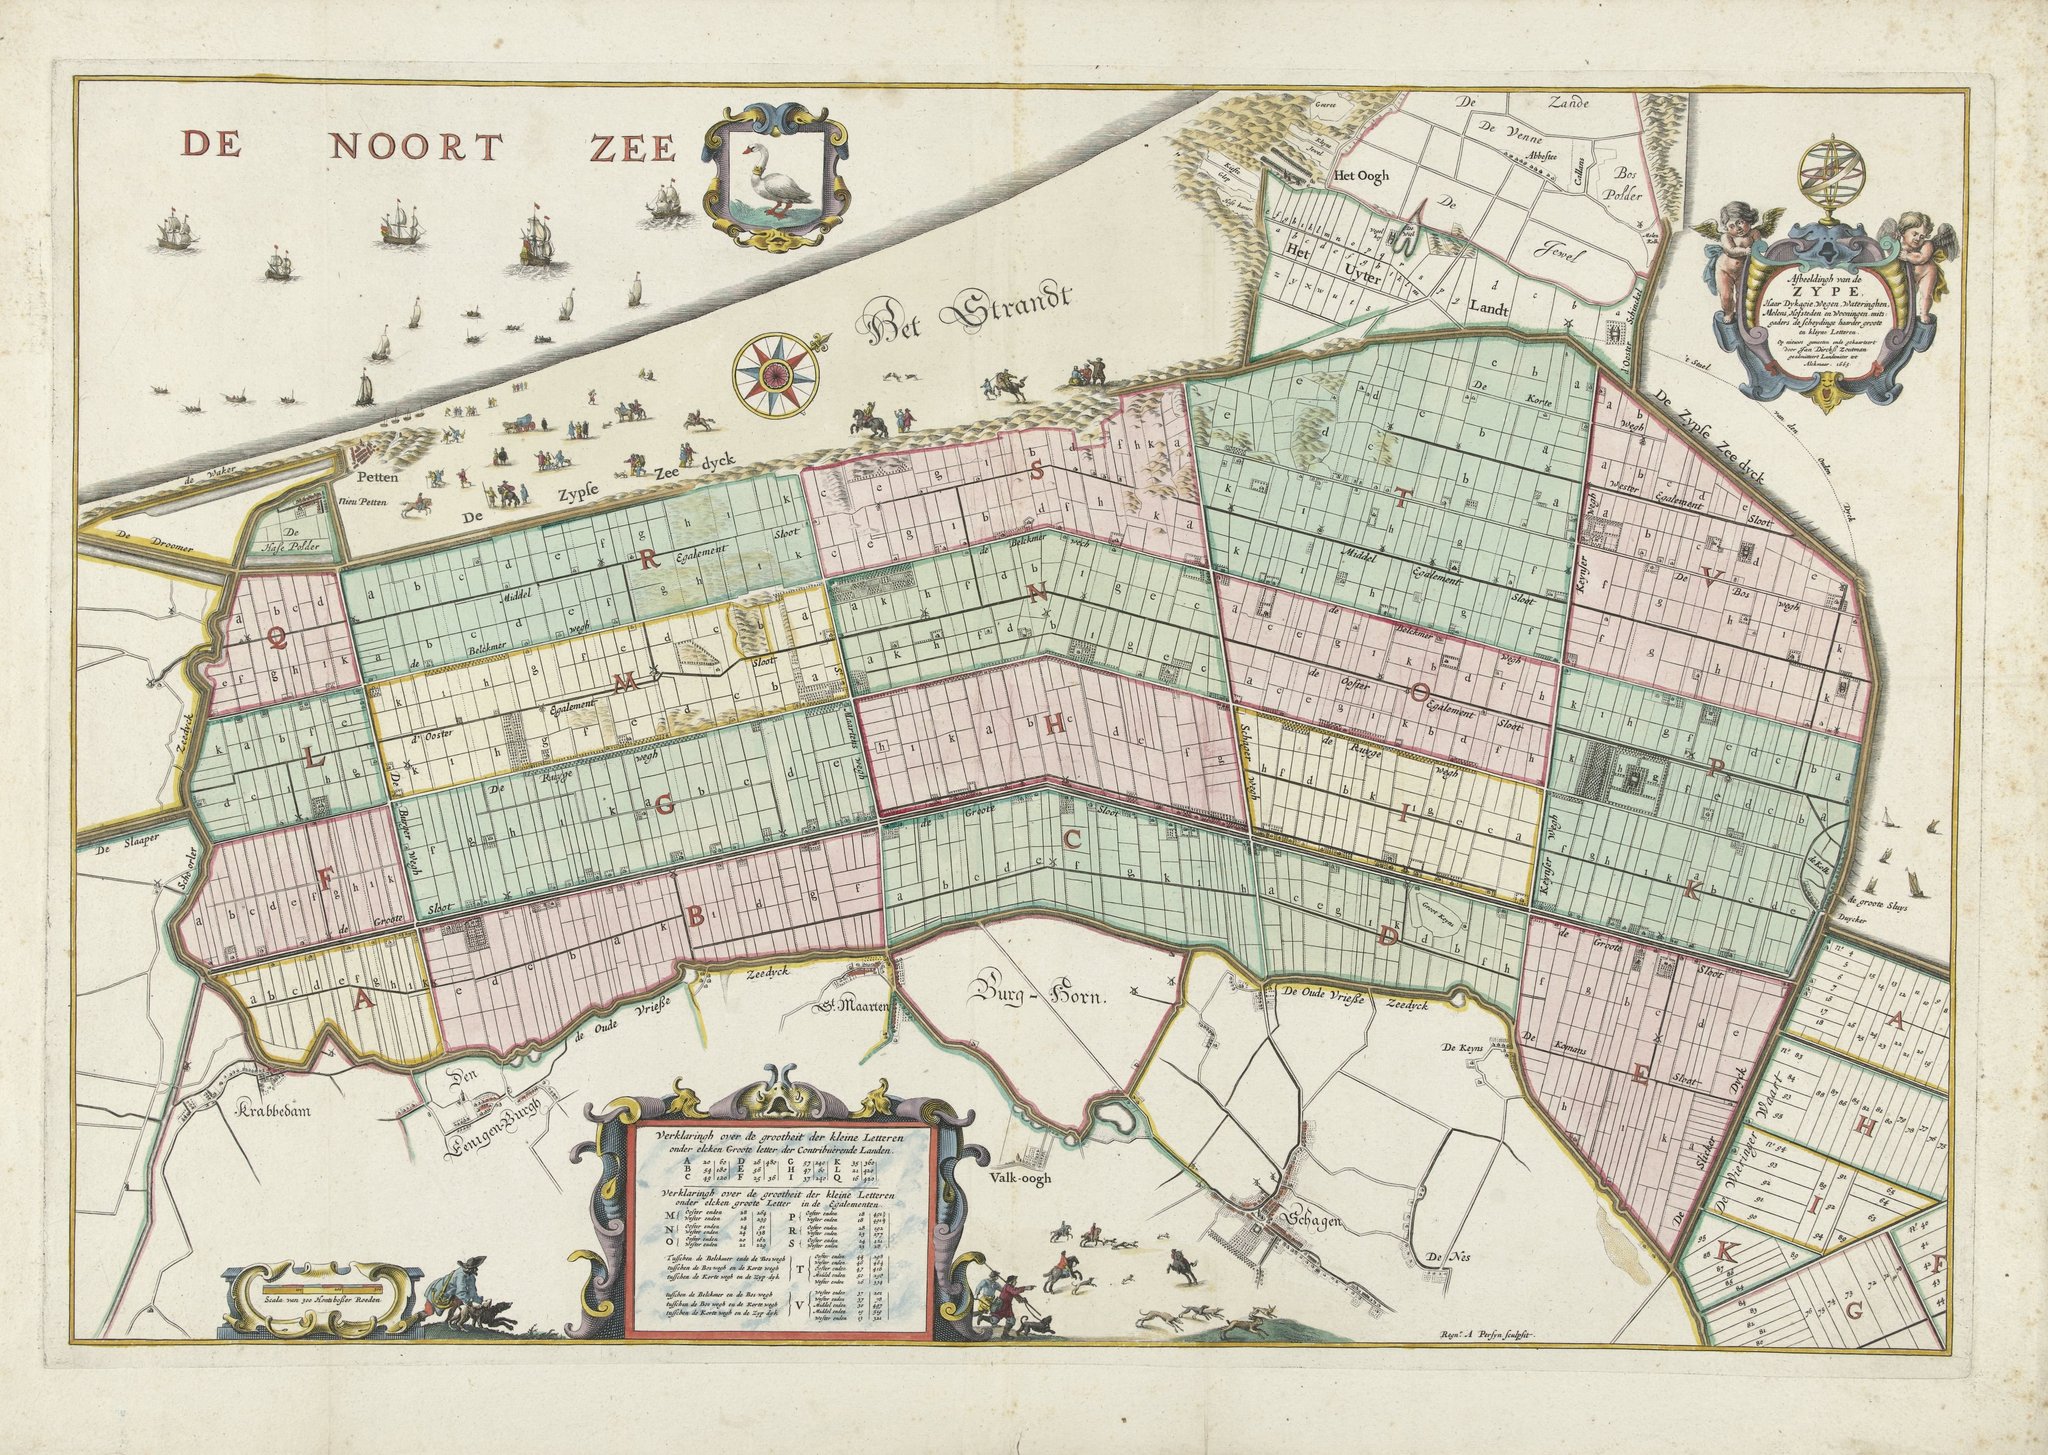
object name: print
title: Kaart van Zijpe en omgeving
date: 1665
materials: paper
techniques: engraving, etching, hand coloring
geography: alkmaar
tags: device (as symbol of the state, etc.) (+ city; municipal), maps, atlases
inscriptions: collector's mark: Lugt 2228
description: Kaart van Zijpe en omgeving. Bovenaan het wapenschild van Zijpe. Onderaan een cartouche met een legenda. Linksonder een schaalverdeling.